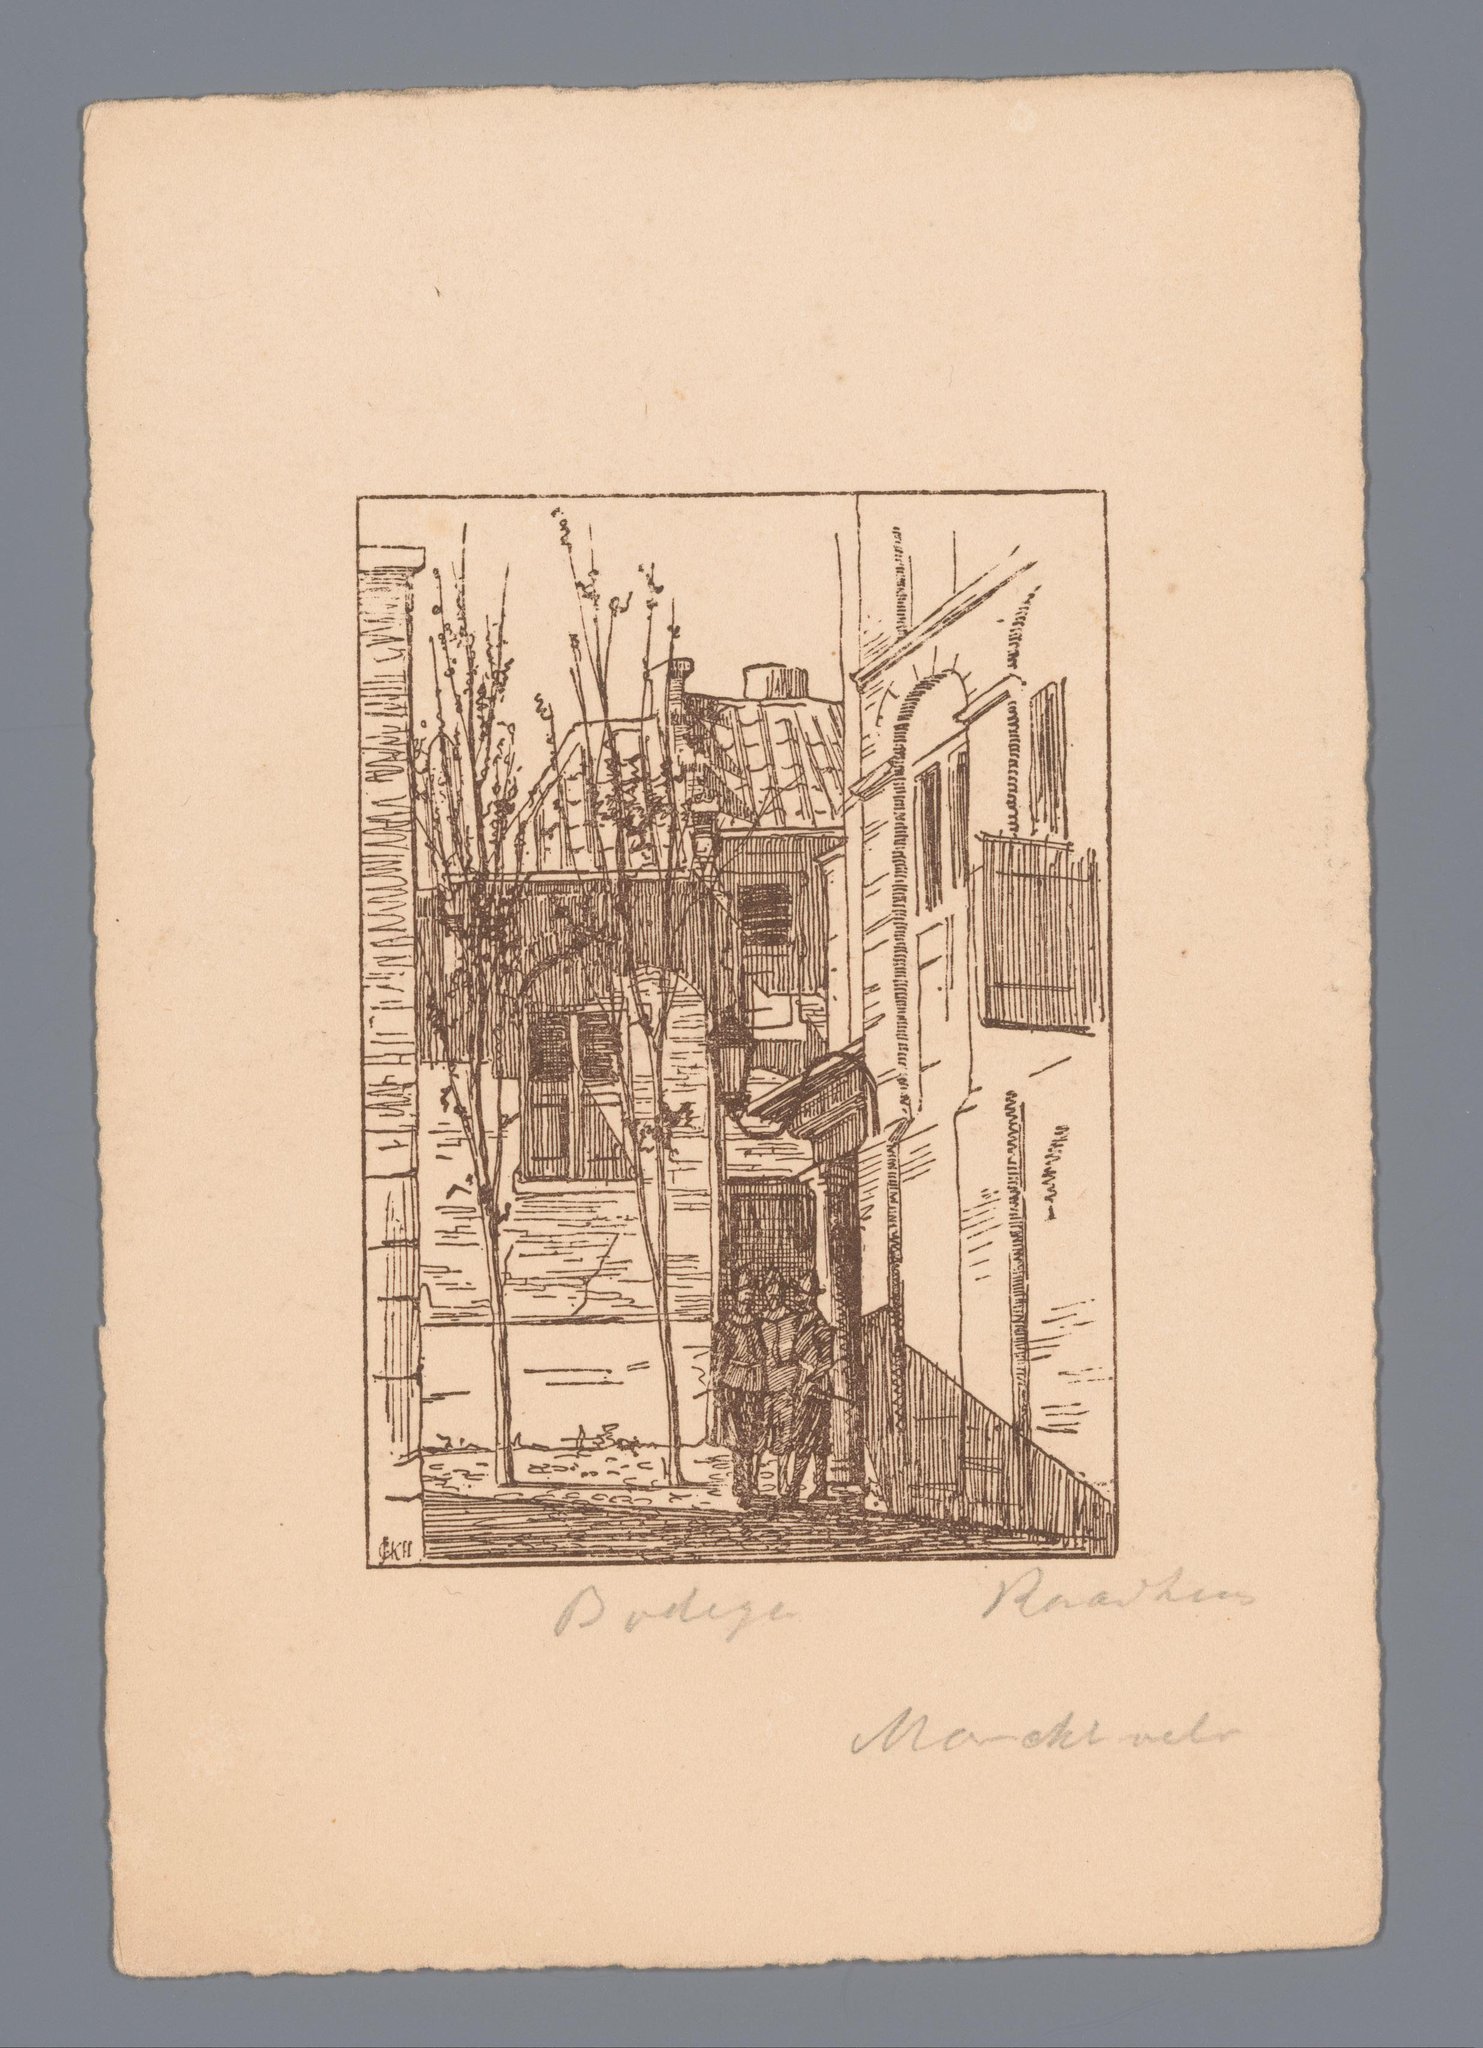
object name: print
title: Gezicht op een straat met drie kletsende soldaten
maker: Anonymous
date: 1800-1899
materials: paper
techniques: lithograph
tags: private soldier (+ infantry), civic architecture; edifices; dwellings, amsterdam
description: Gezien de kleding van de soldaten en hun helmen, lijkt de afbeelding in de 16e/17e eeuw te plaatsen, mogelijk tijdens de 80-jarige oorlog.